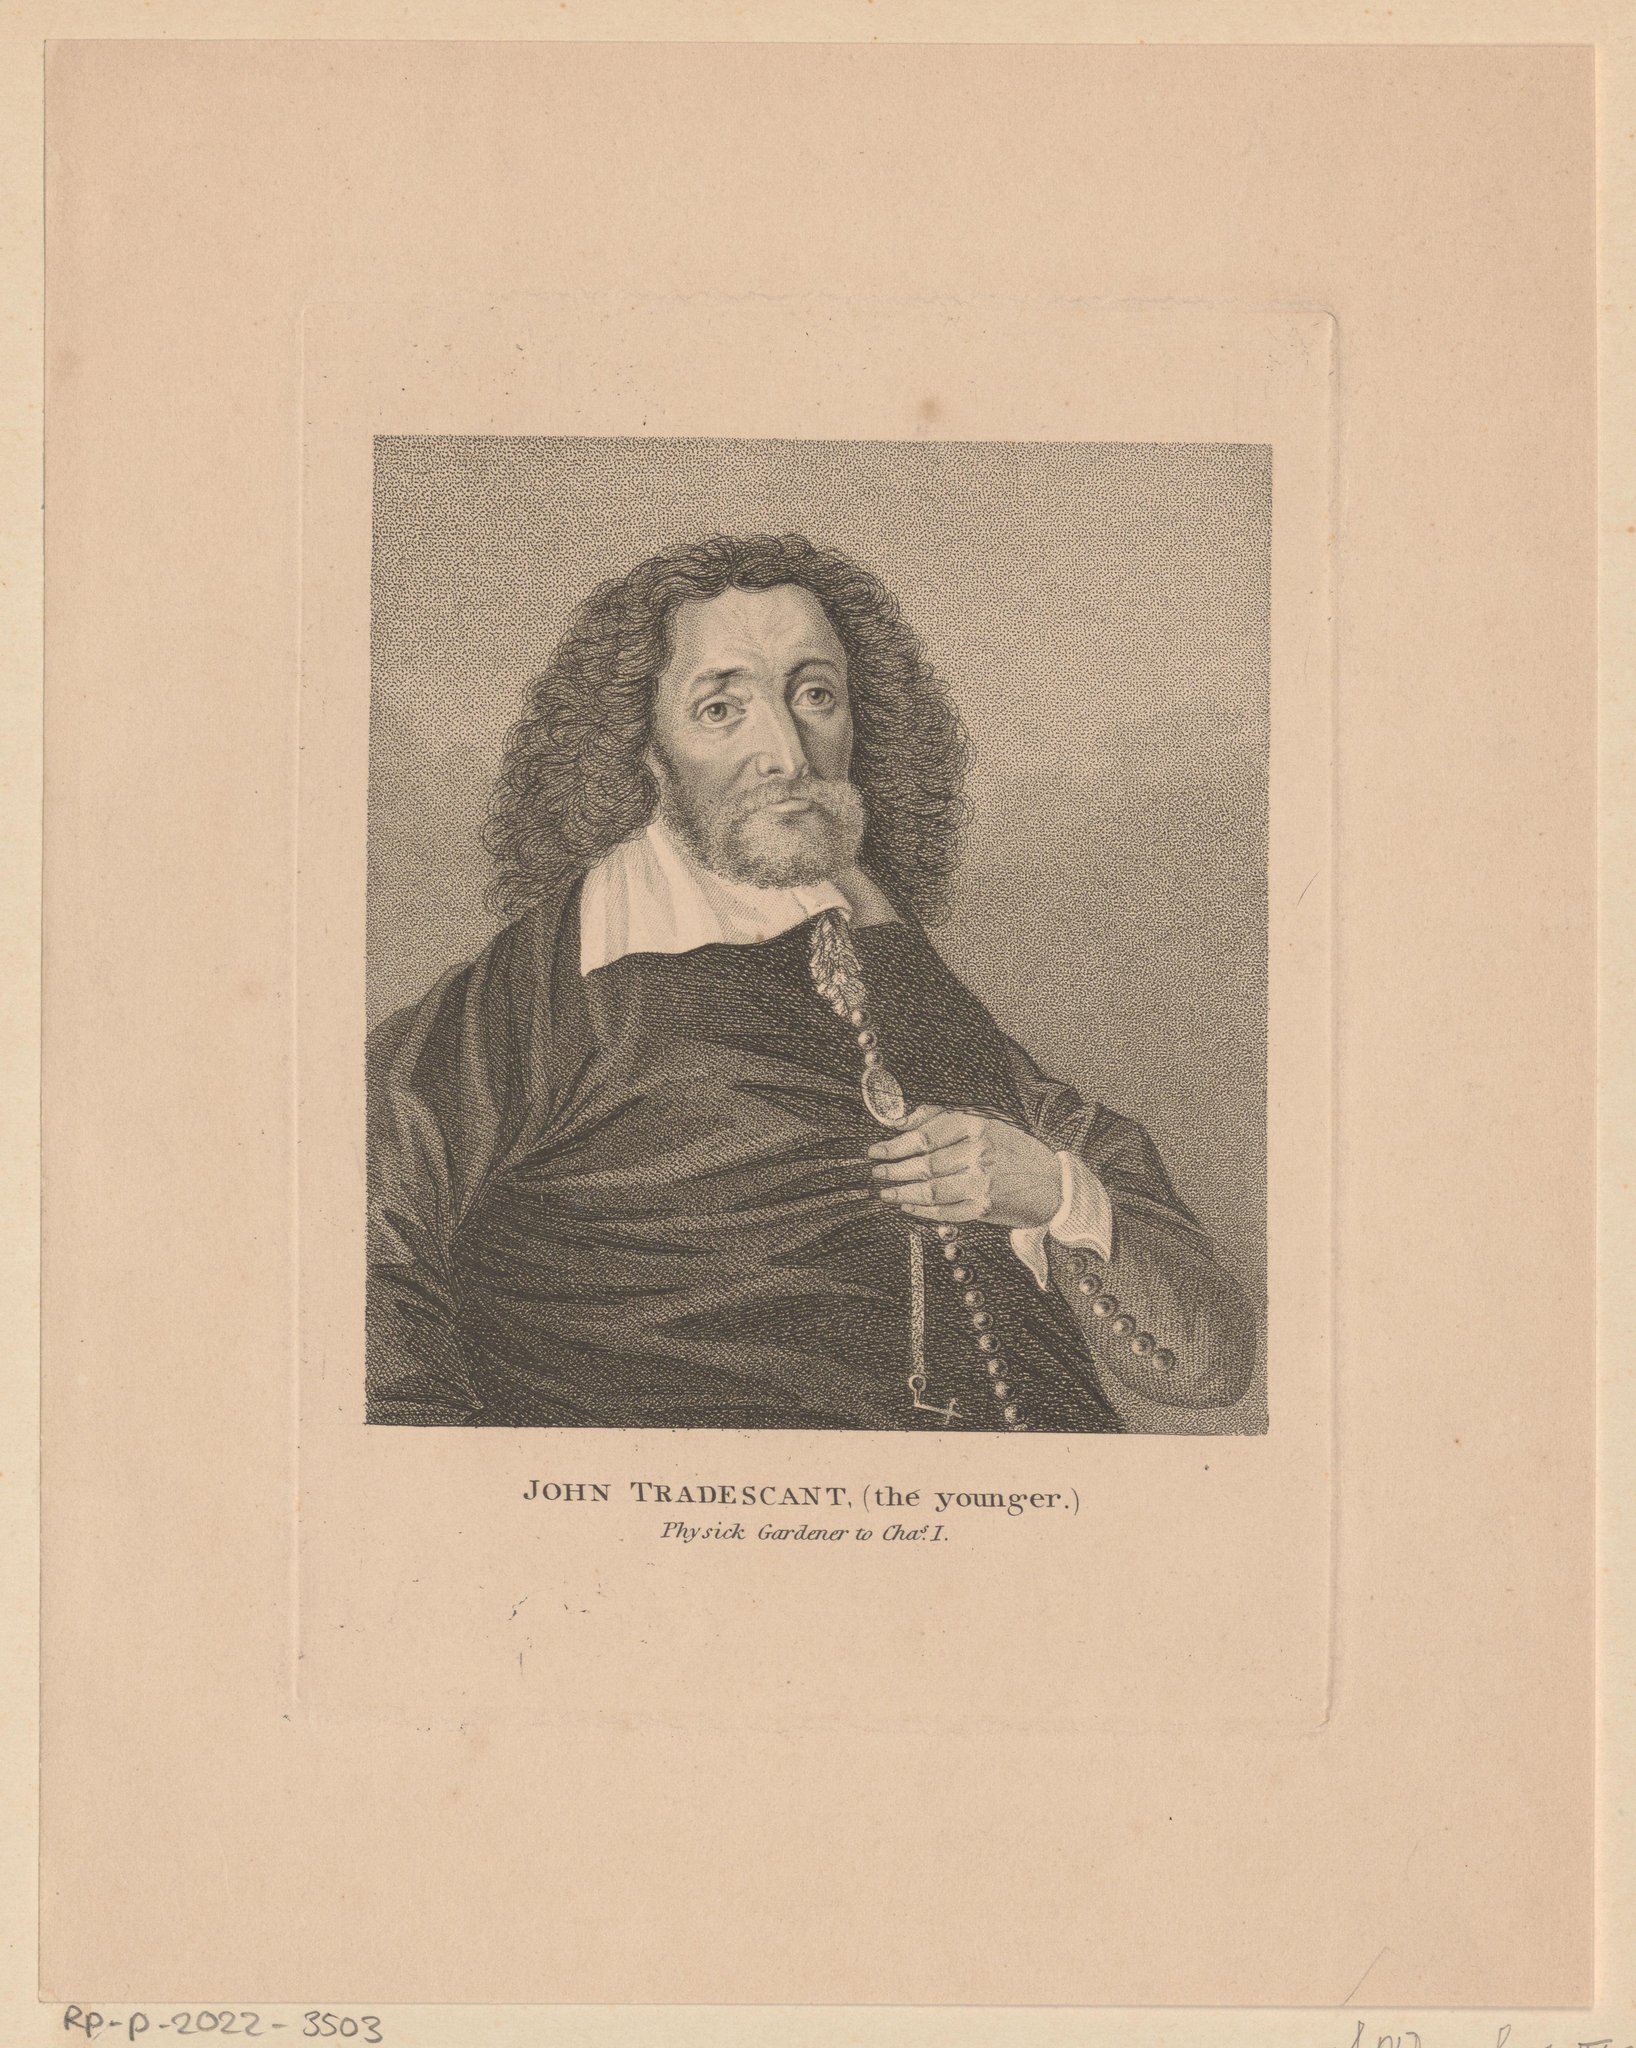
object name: print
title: Portret van John Tradescant (II)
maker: Anonymous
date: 1800-1899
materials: paper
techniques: etching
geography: united kingdom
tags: historical persons